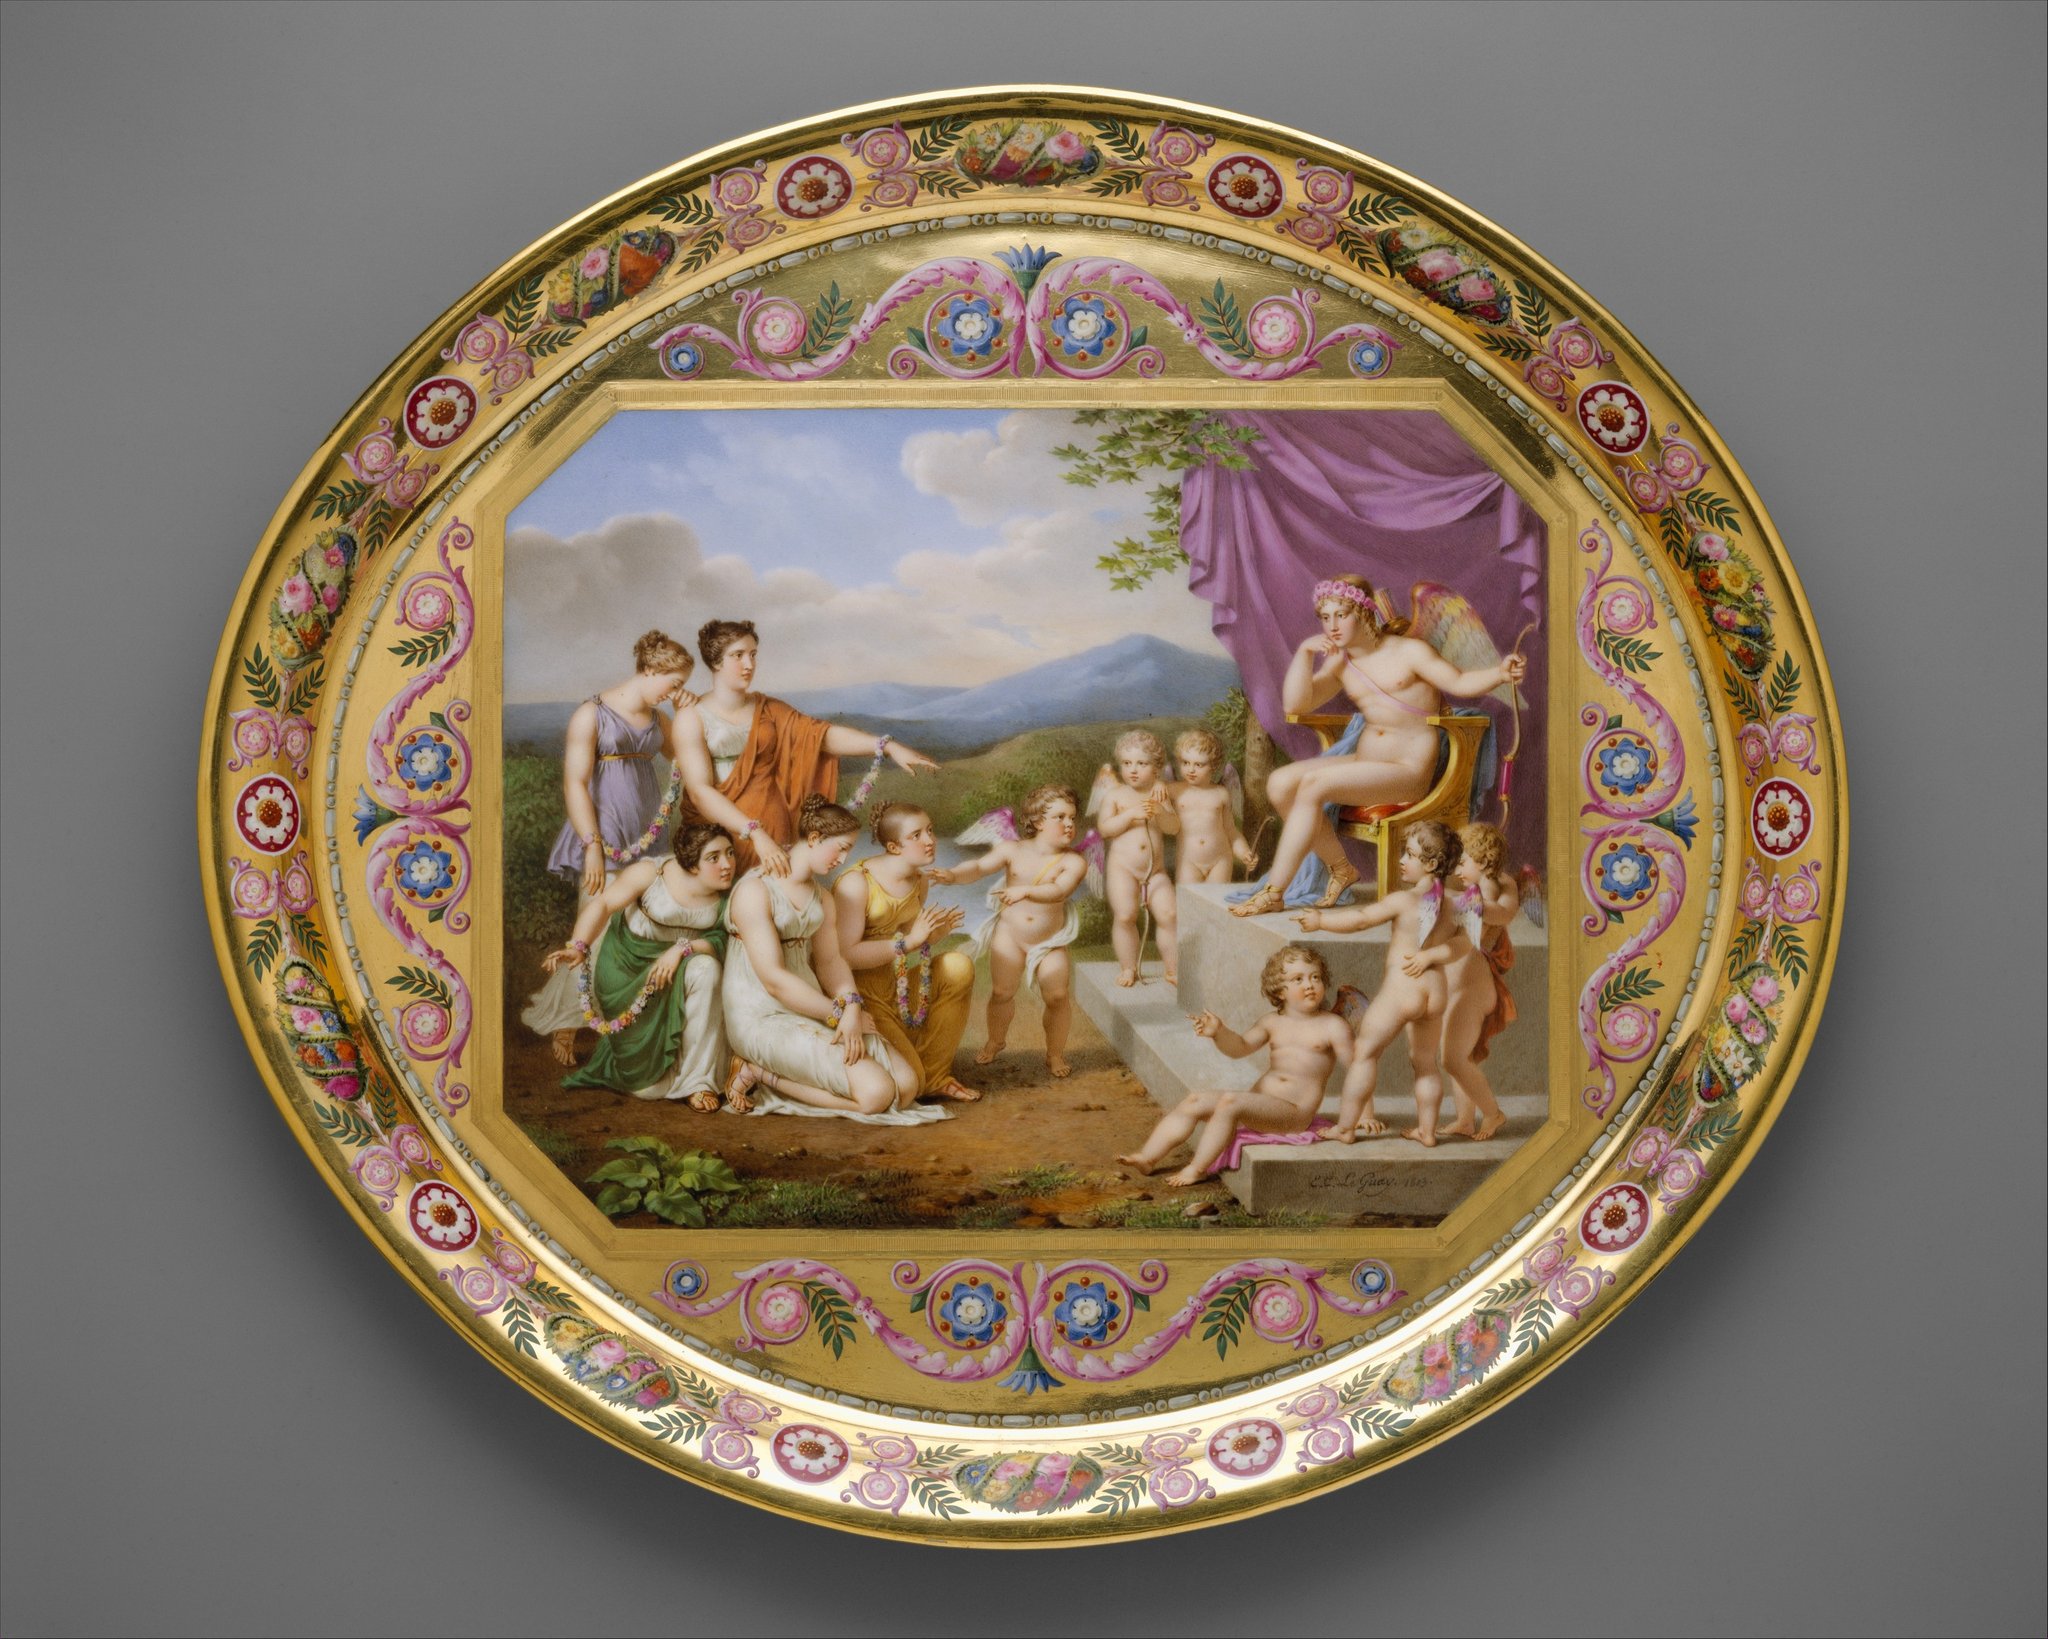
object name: tray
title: Tray (plateau), part of Breakfast Service (déjeuner)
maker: sèvres manufactory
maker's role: manufactory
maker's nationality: french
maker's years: 1740-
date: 1813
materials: hard paste porcelain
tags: women,putti